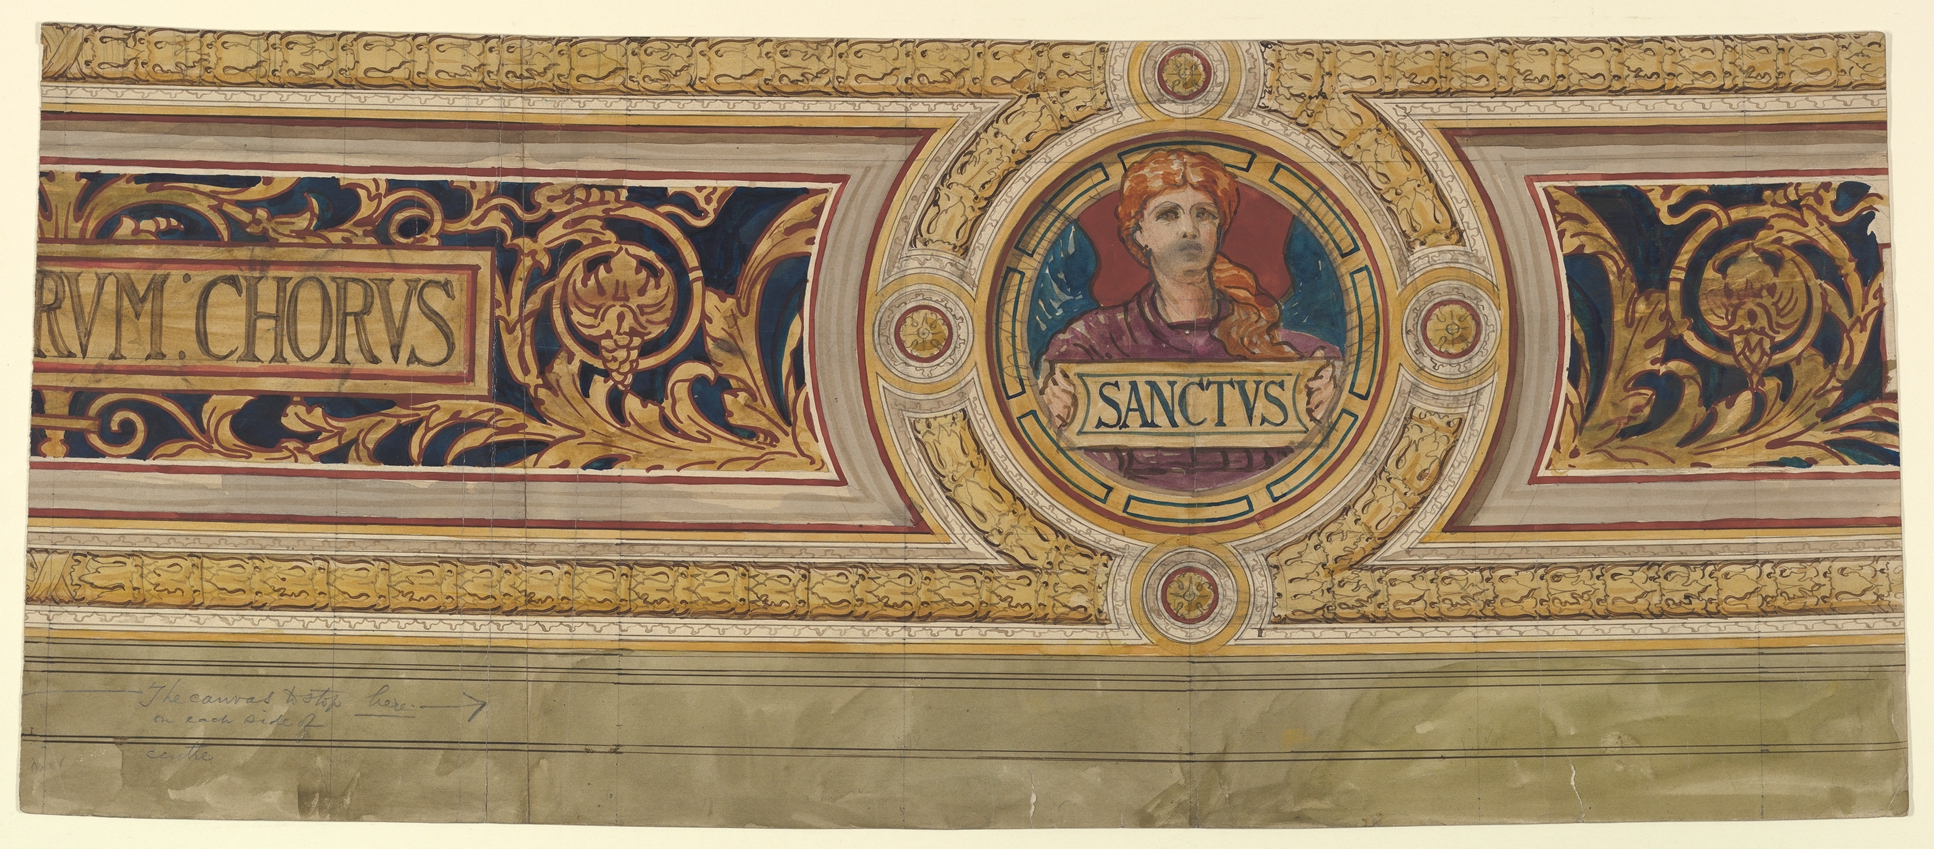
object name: drawing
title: Frieze decoration: Sanctus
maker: h. stannus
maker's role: artist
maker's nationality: british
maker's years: 19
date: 1801-1900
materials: watercolor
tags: ornament,heads